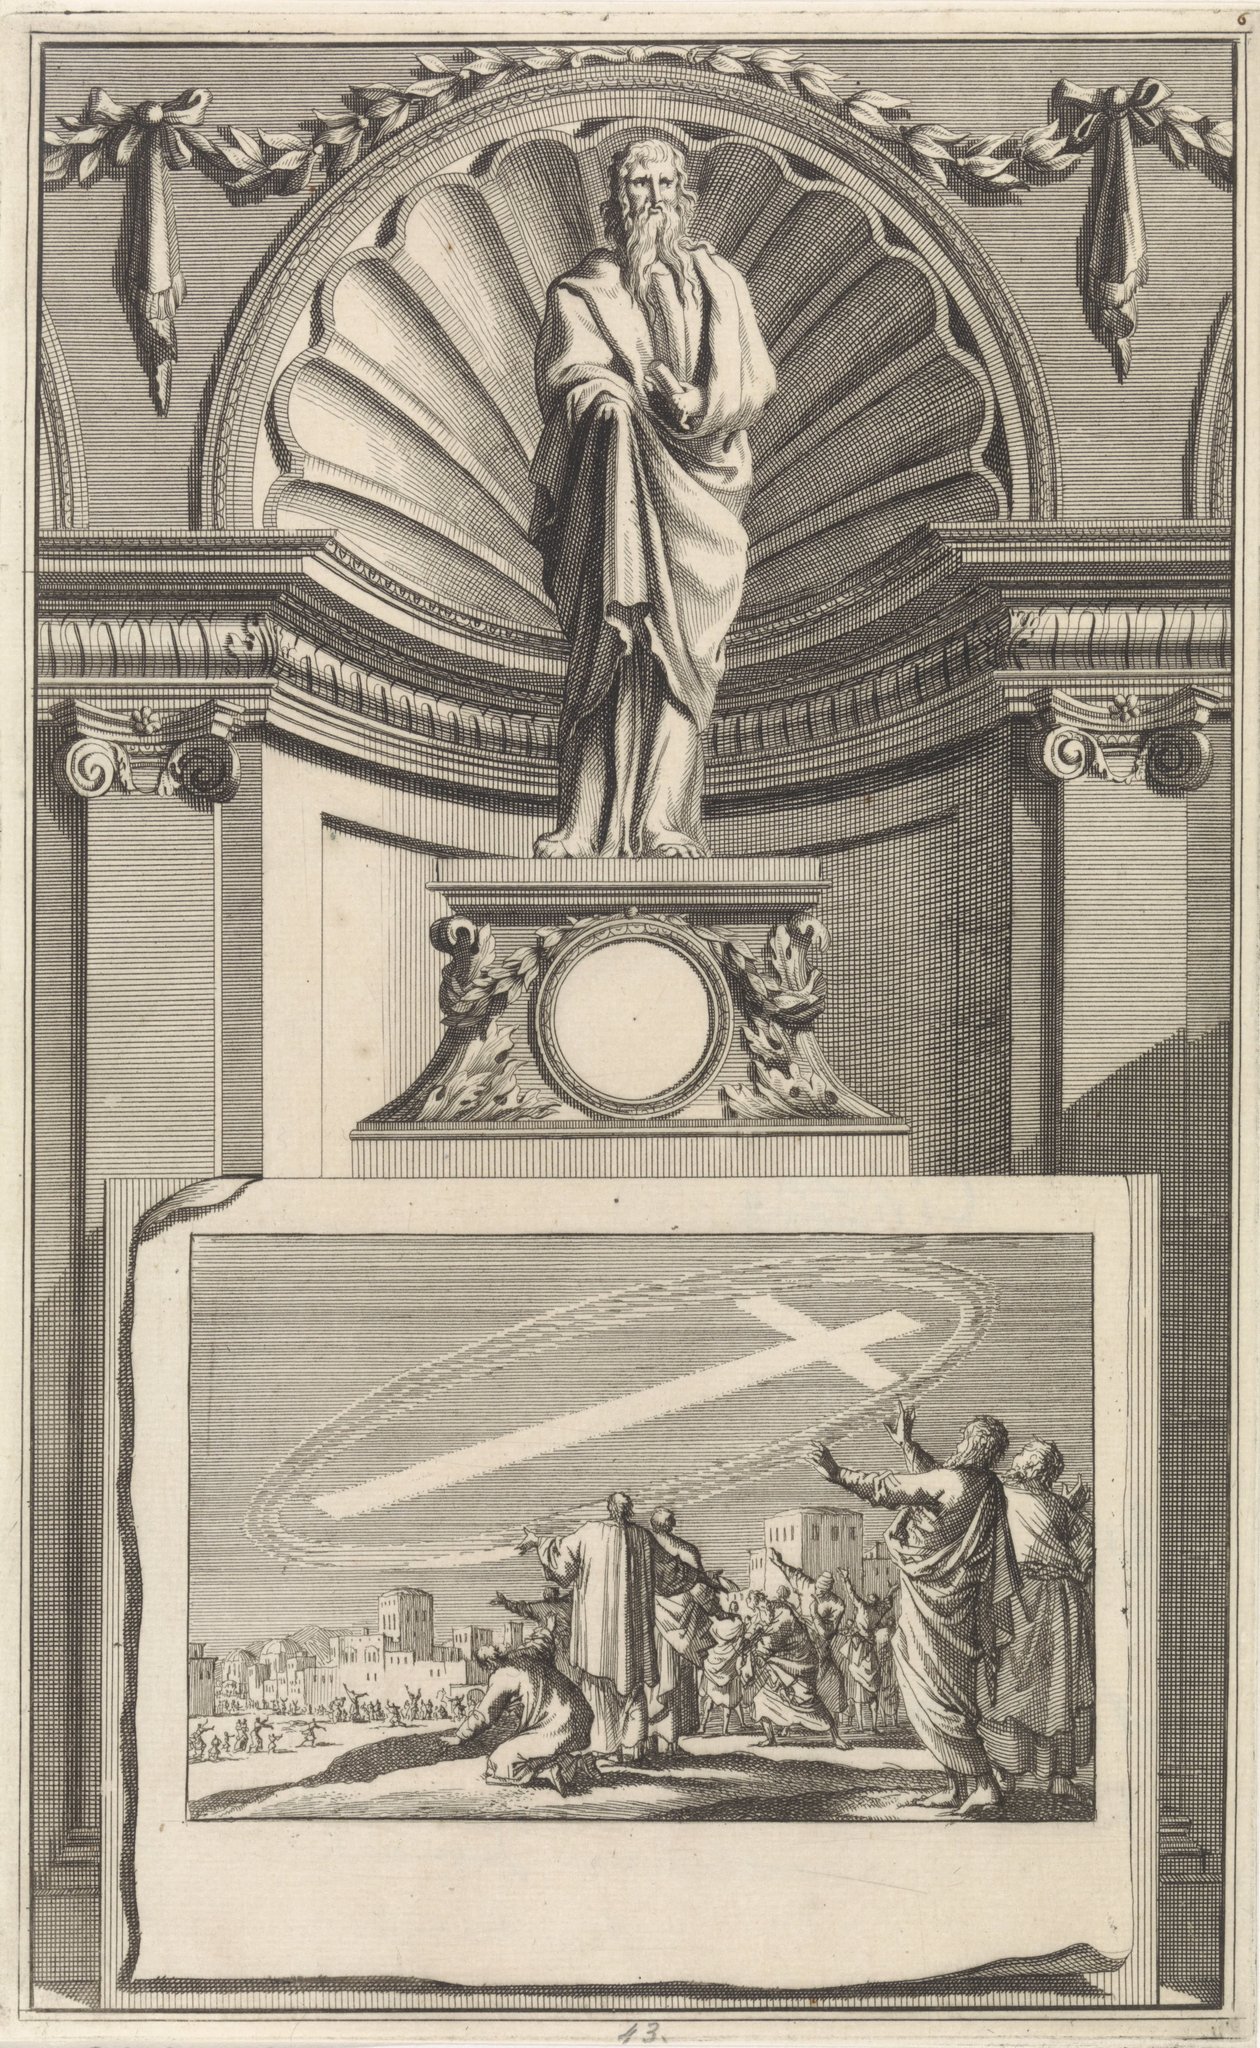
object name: print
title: H. Cyrillus van Jeruzalem, kerkleraar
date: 1698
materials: paper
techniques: engraving, etching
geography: amsterdam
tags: appearances, male saints (cyril of jerusalem)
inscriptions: collector's mark: Lugt 2228, number: ‘6’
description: De heilige kerkleraar Cyrillus van Jeruzalem, staand op een sokkel. Op de voorzijde de scène waarin een lichtend kruis omgeven door een regenboog in de lucht boven Jeruzalem is verschenen.